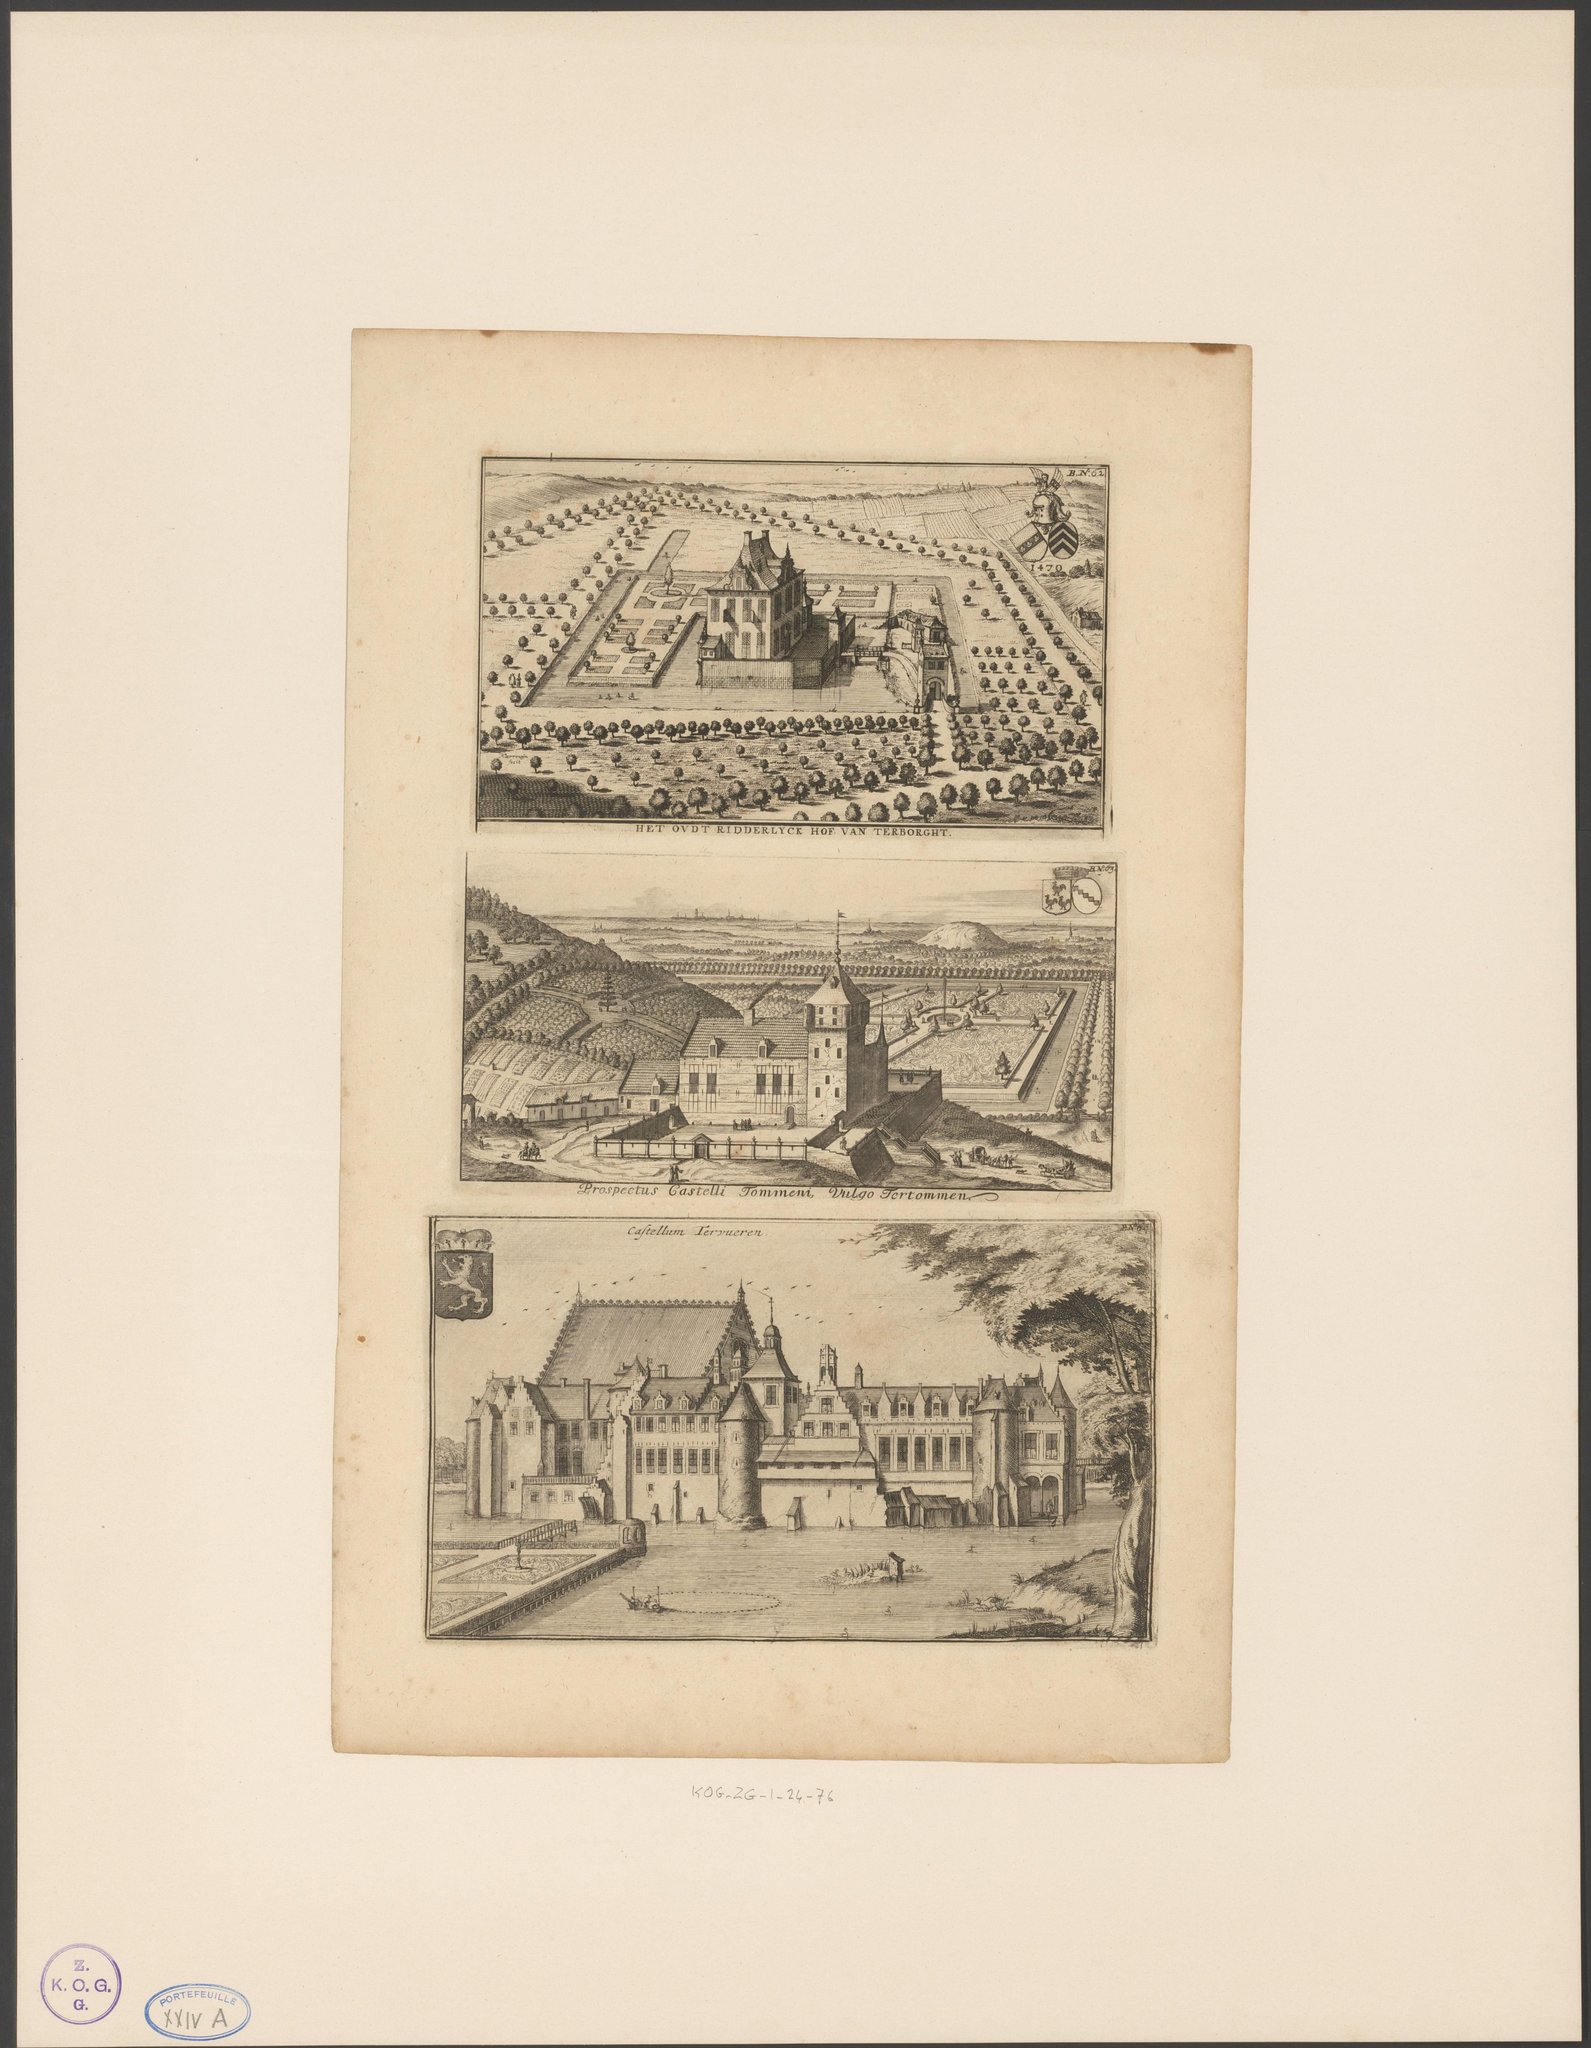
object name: print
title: Gezichten op Kasteel Terborgt, Kasteel ter Tommen en Kasteel van Tervuren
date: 1750-1799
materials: paper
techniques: engraving, etching, retroussage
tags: castle, rural housing, e.g. country-house, villa, cottage, landscape with tower or castle, armorial bearing, heraldry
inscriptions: stamp, collector's mark: Lugt 1641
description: Bovenste en middelste plaat hebben rechtsboven een wapenschild. Onderste plaat heeft linksboven een wapenschild. Iedere prent is rechtsboven genummerd: C.No. 62, C.No. 63, C.No. 64. Onderwerpsrubrieken binnen de Atlas Zeden en Gewoonten: Zeden en Gewoonten in Engeren Zin, De Woning. Kastelen en buitenplaatsen. Over de Grenzen.